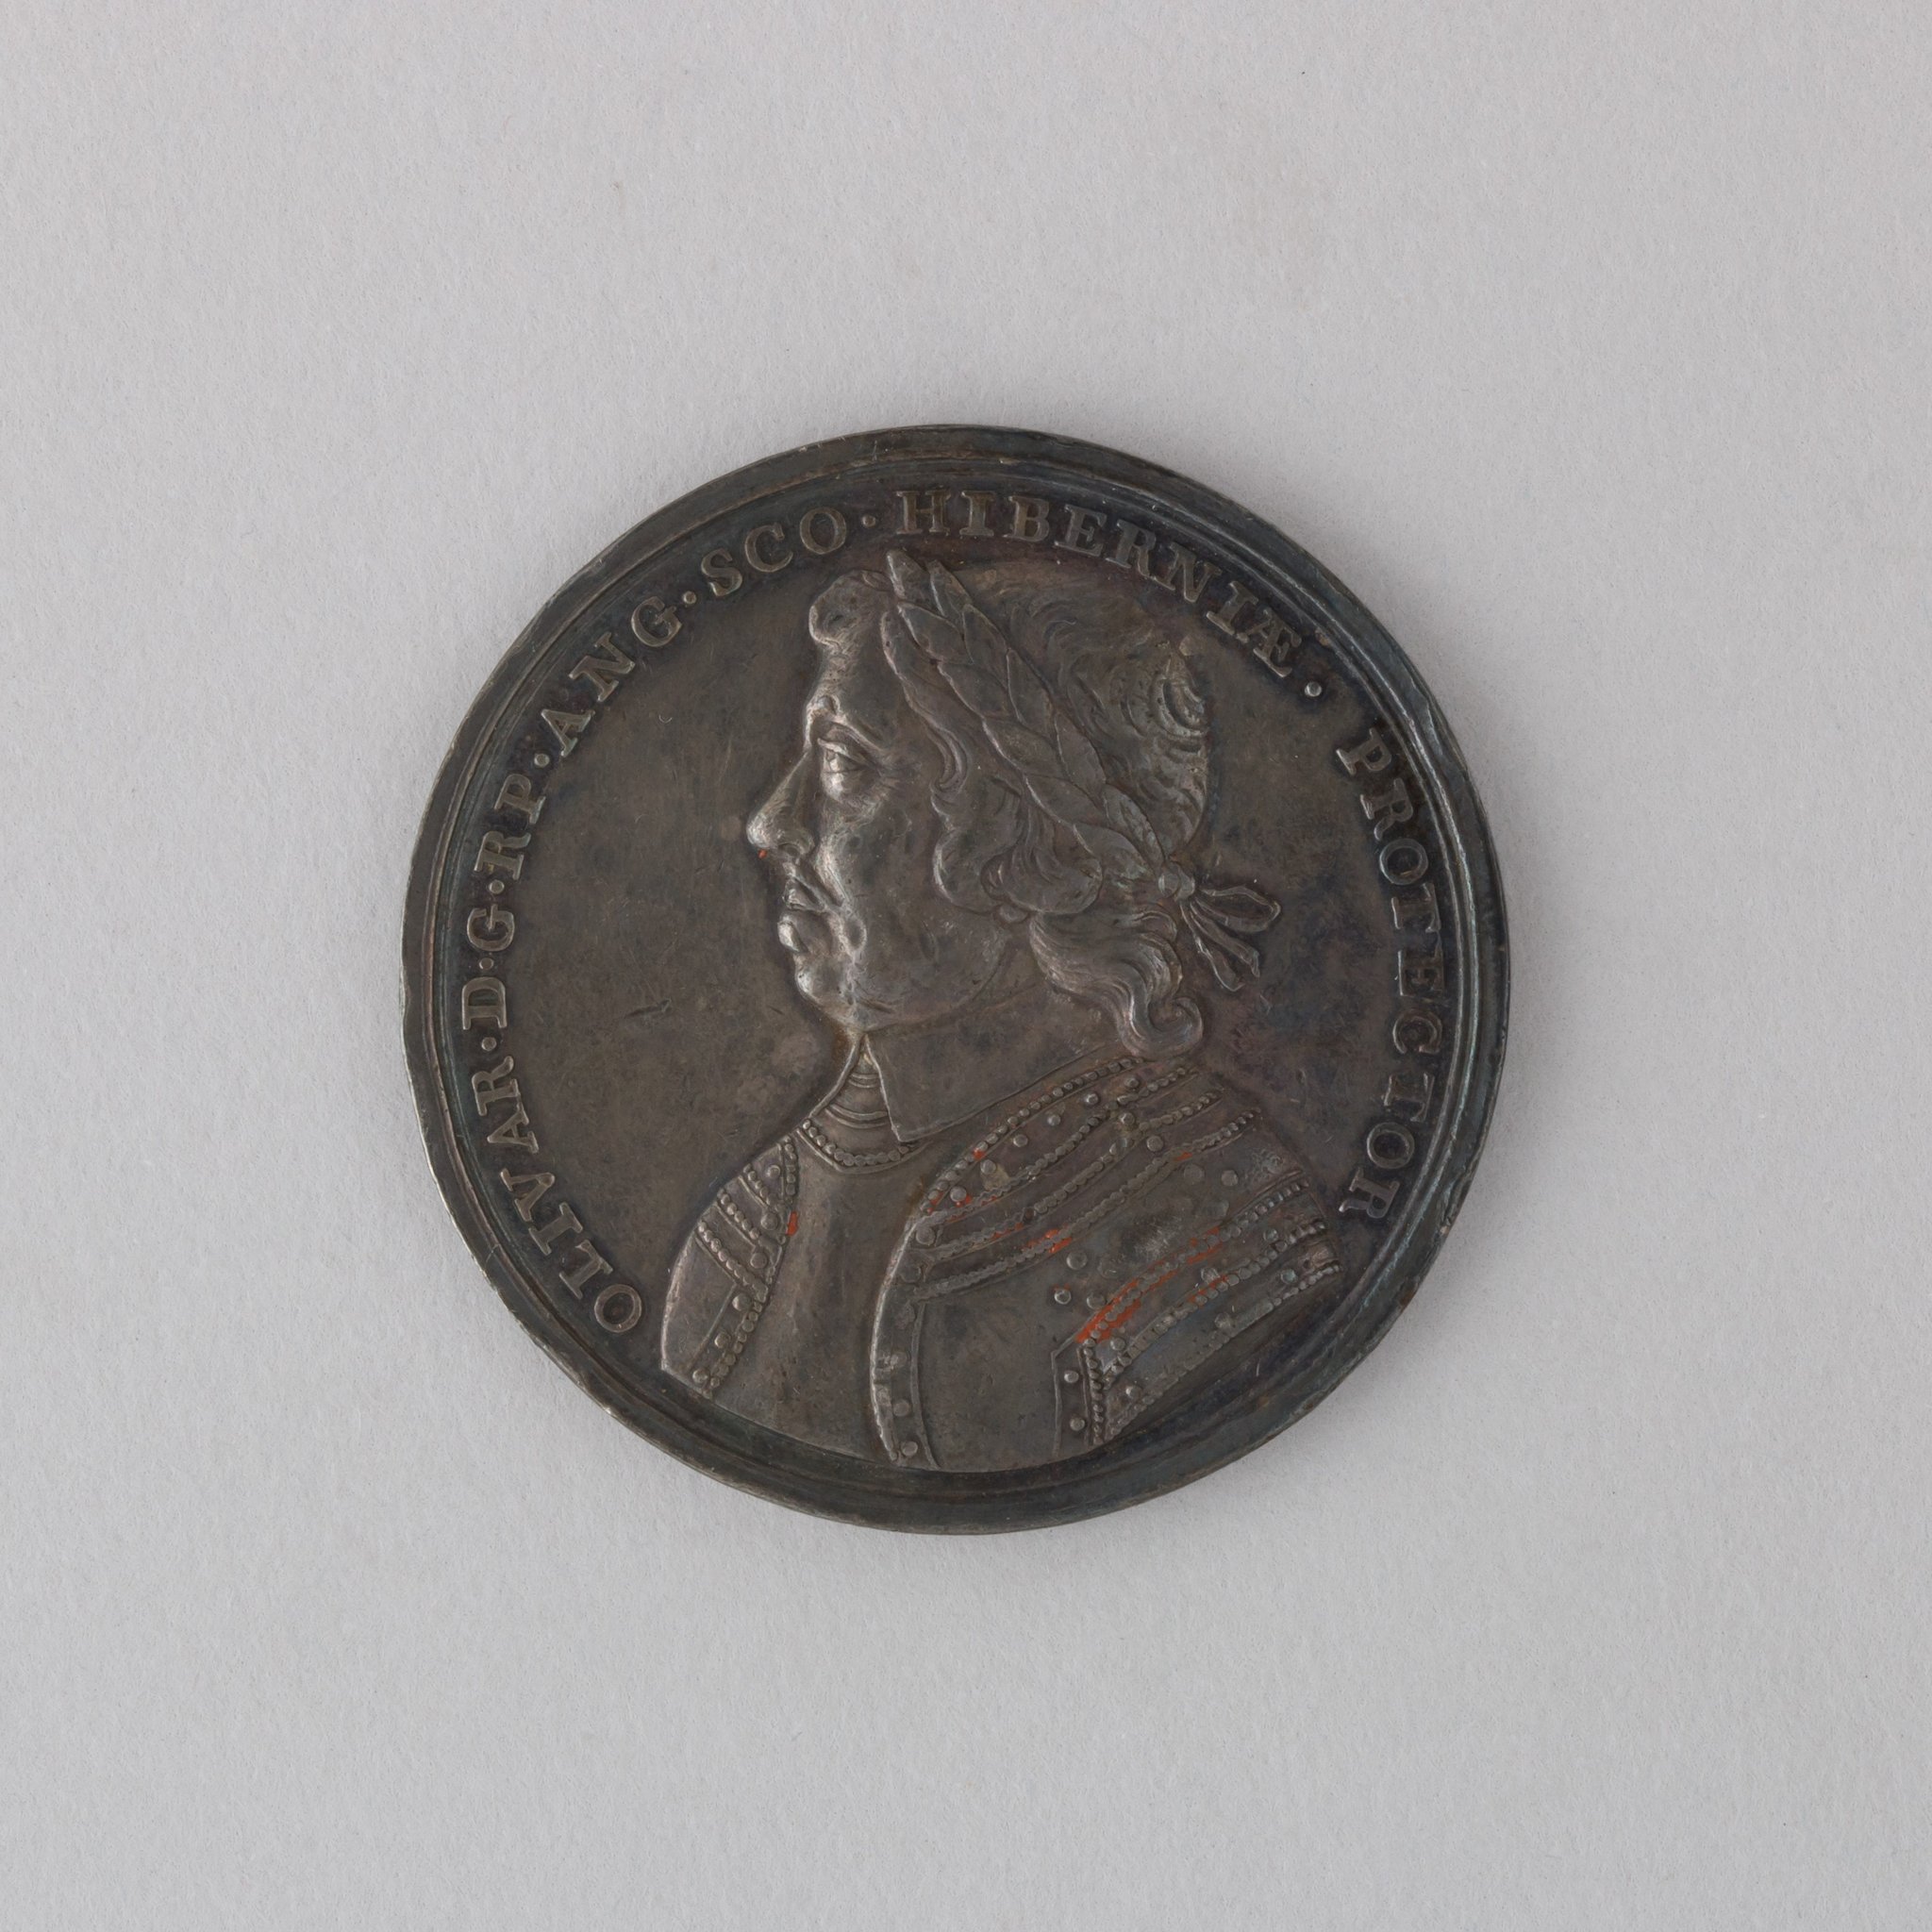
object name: medal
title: Medal Commemorating the Death of Cromwell, 1658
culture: british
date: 1601-1700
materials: silver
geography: england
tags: men,profiles